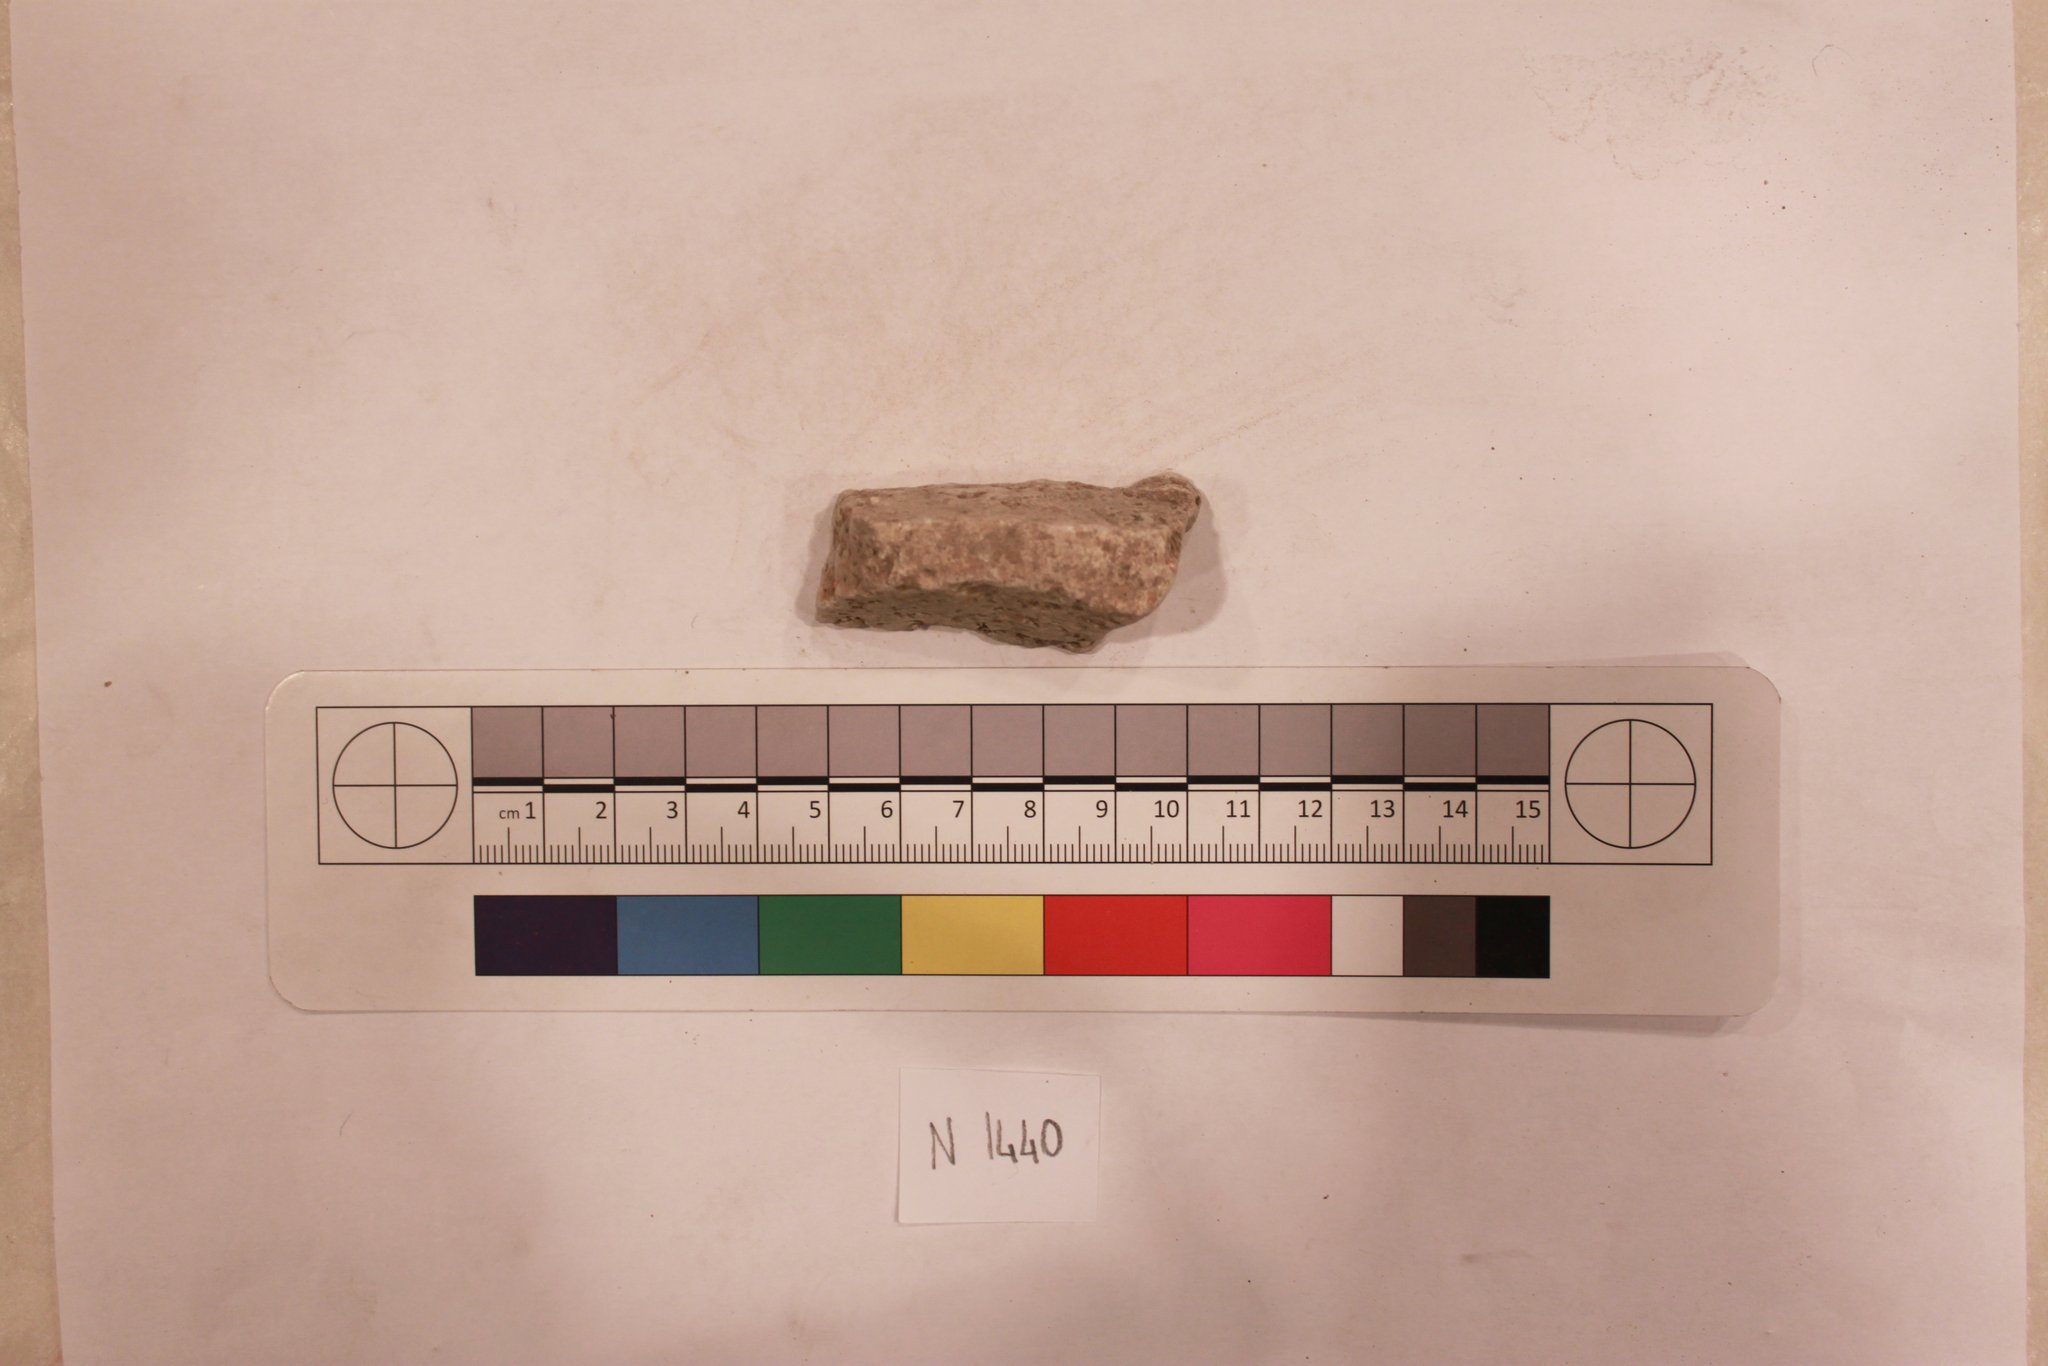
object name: fragment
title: Stucco Fragment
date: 701-1200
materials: plaster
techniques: carving, painting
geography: iran